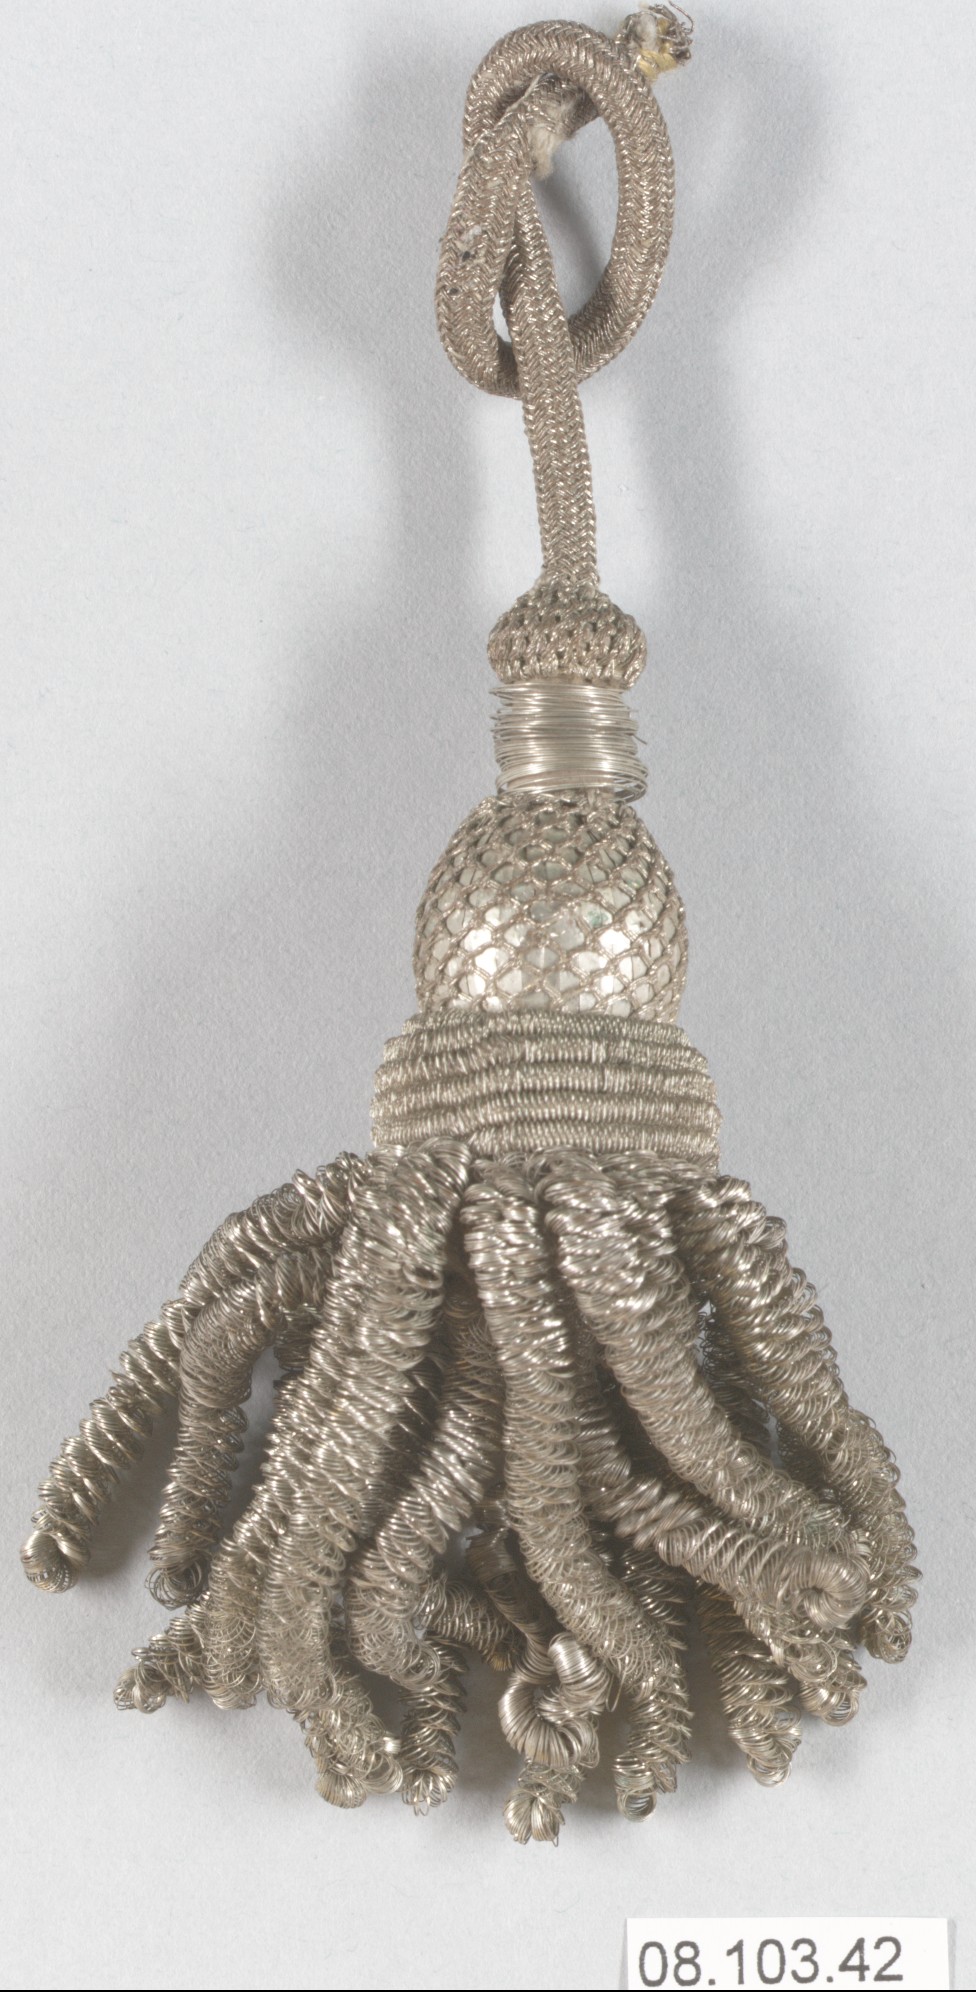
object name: tassel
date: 1701-1900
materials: metal thread